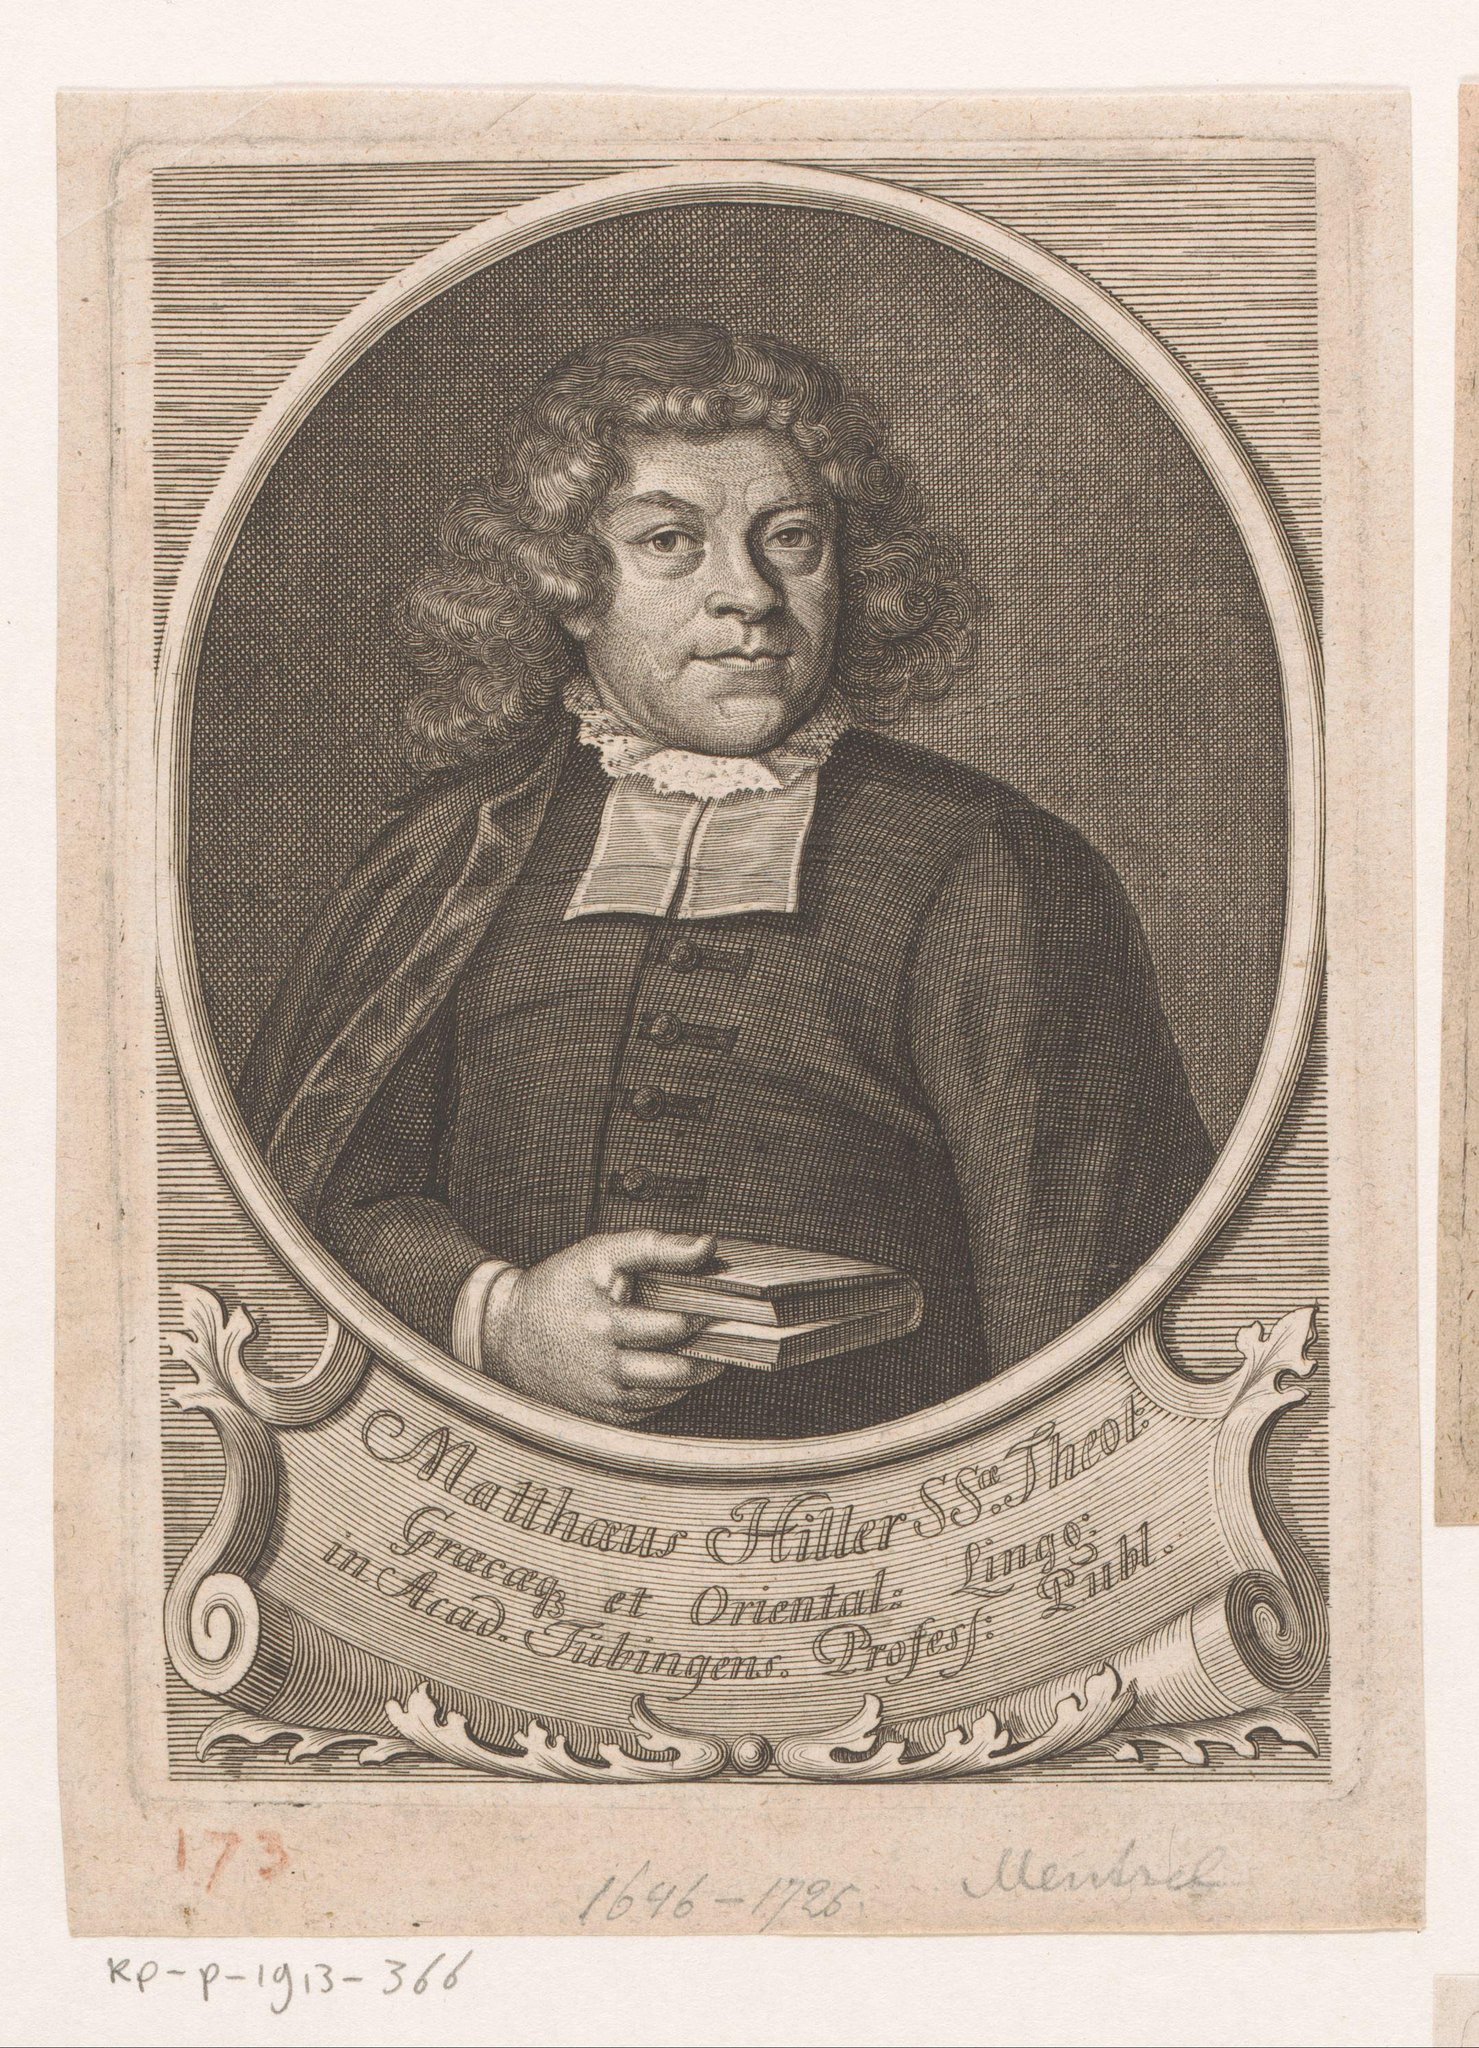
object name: print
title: Portret van Matthäus Hiller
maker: johann georg mentzel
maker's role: print maker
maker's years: 1677-1743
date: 1687-1743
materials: paper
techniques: engraving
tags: theologian, historical persons, book, wig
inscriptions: collector's mark: Lugt 2228